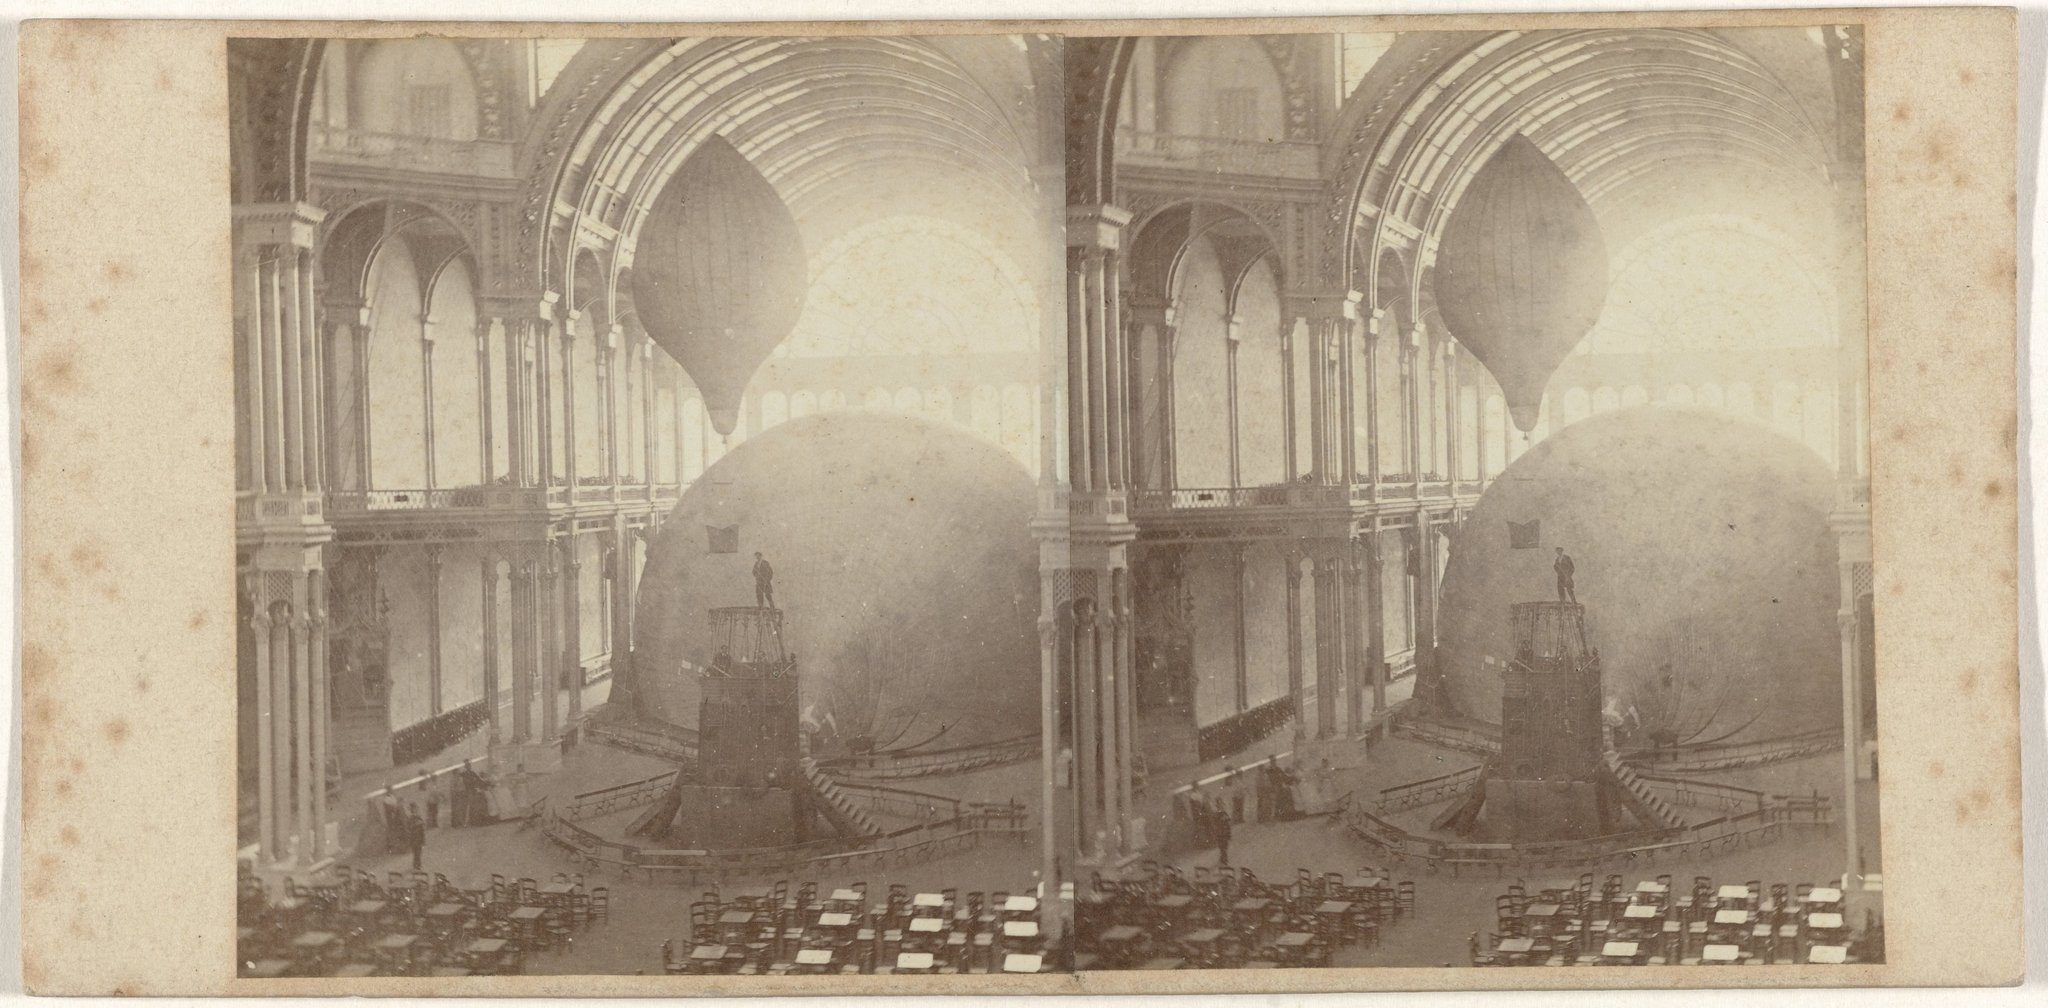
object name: stereograph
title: Amsterdam. Paleis voor Volksvlijt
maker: jan dirk brouwer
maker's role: publisher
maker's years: 1835-1898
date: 1863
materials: cardboard, paper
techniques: albumen print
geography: amsterdam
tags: balloon (aviation)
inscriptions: retailer's mark: ‘BOEKHANDEL/ JAN D. BROUWER./ KALVERSTRAAT E. No 37/ AMSTERDAM.’